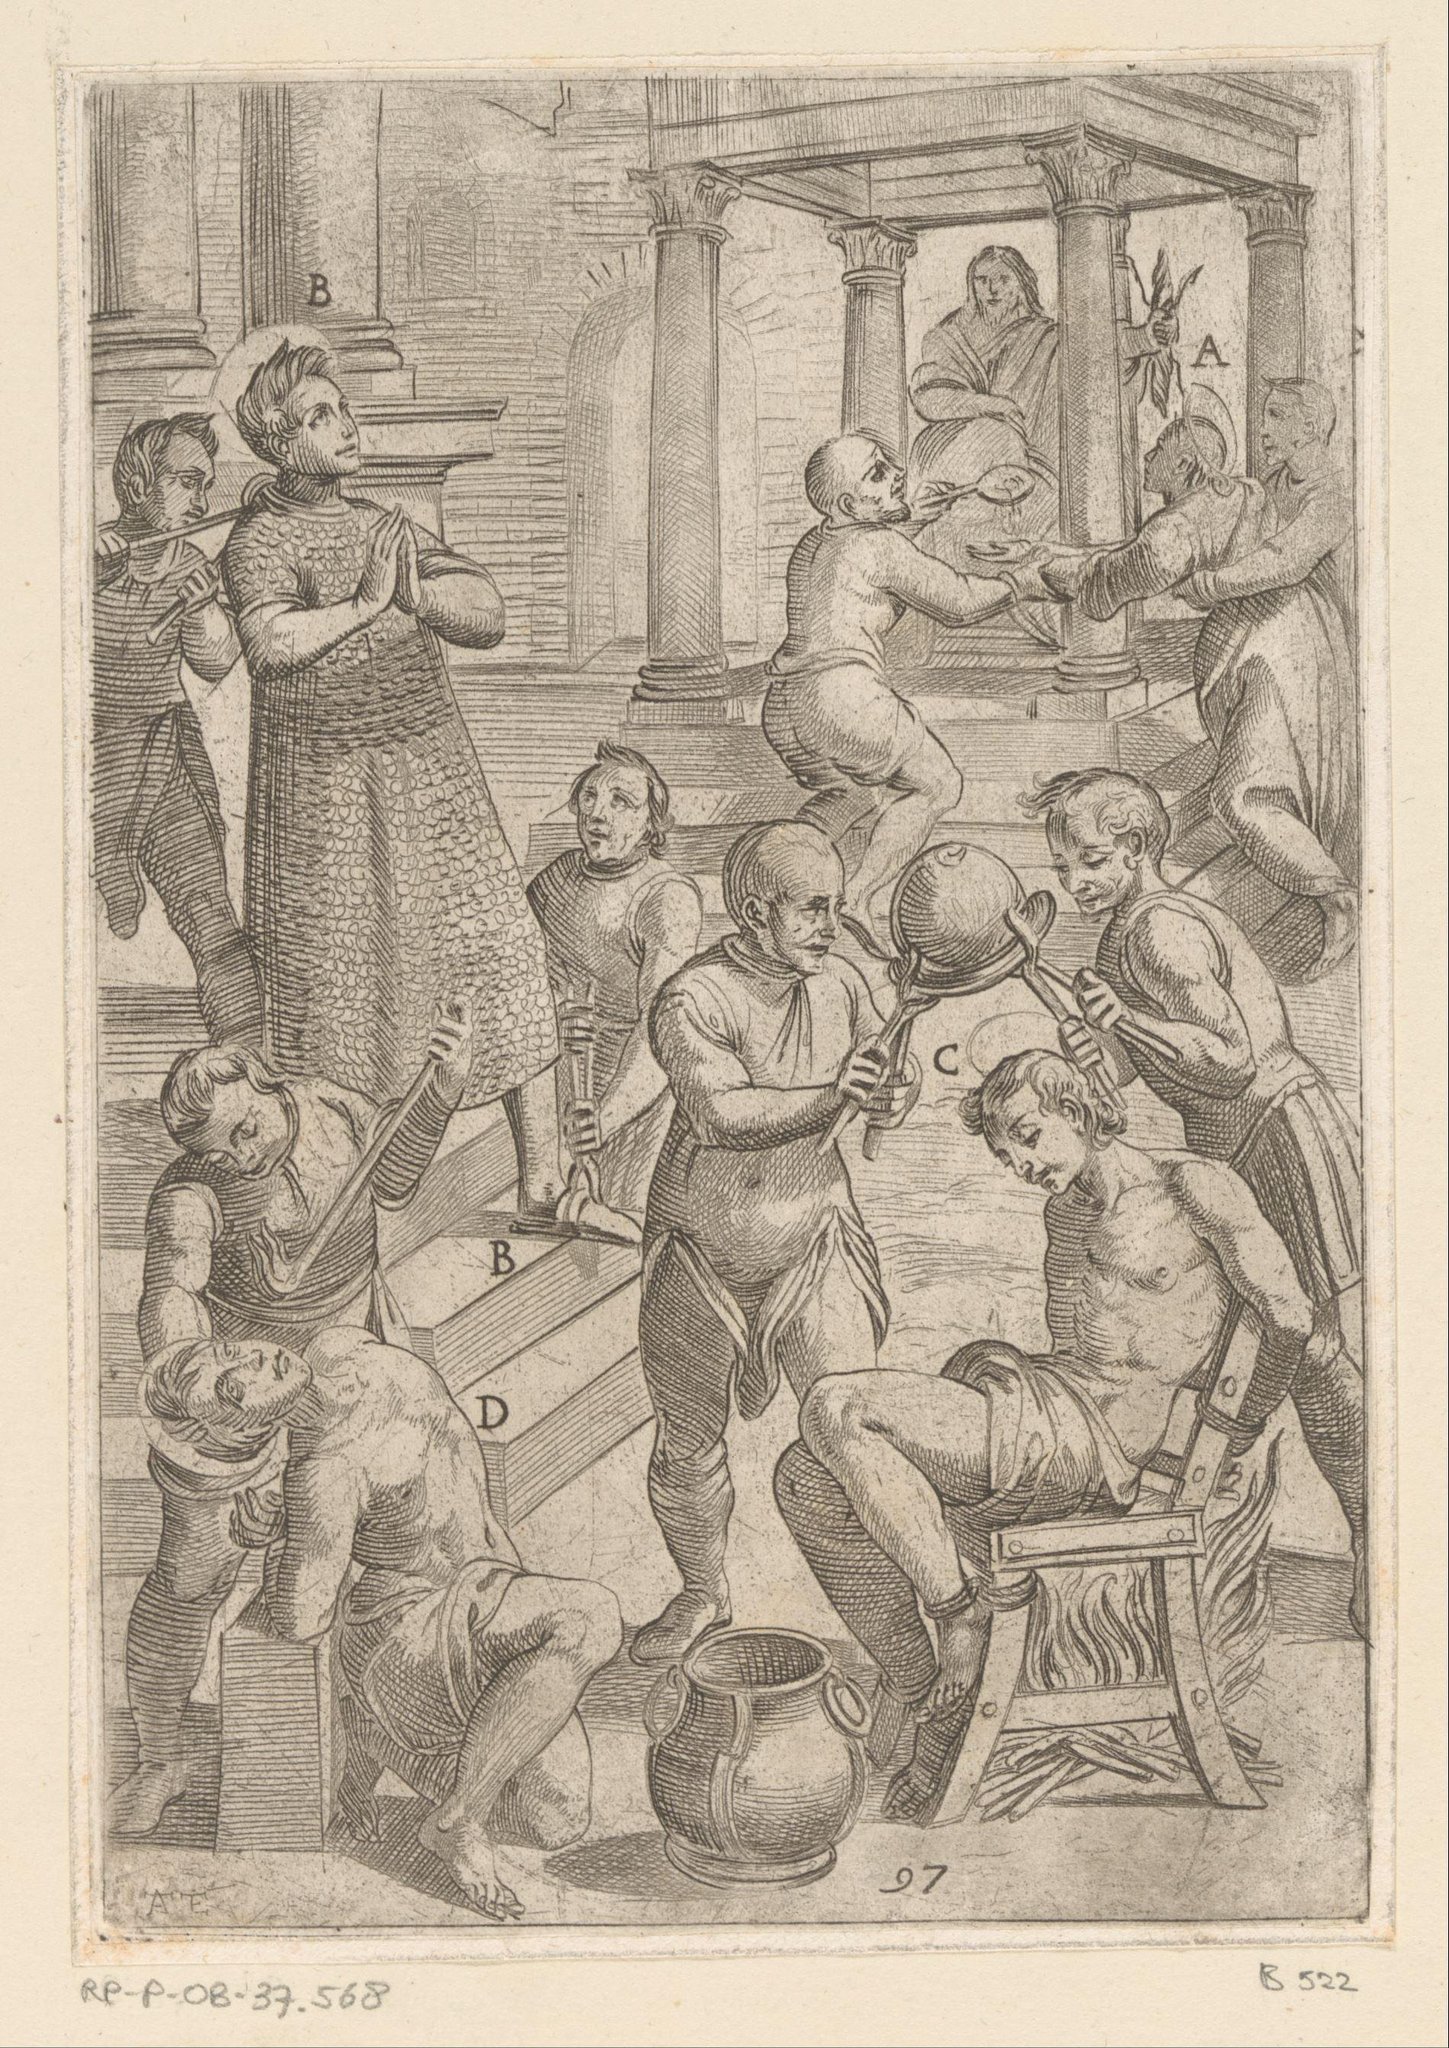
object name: print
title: Foltering: verbranding en wurging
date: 1565-1630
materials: paper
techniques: etching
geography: rome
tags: violent death ~ maltreatment, torture, torture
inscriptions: collector's mark: Lugt 240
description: Deze prent maakt deel uit van een reeks van 47 prenten (+ titelprent) met voorstellingen van martelmethoden. Deze prenten zijn in een andere editie gebruikt als illustraties voor Antonio Gallonio's 'Trattato degli Instrumenti di Martirio e delle Varie Maniere di Martoriare Usate dai Gentili contro Christiani' (Rome, Ascanio en Girolamo Dongangeli, 1591).